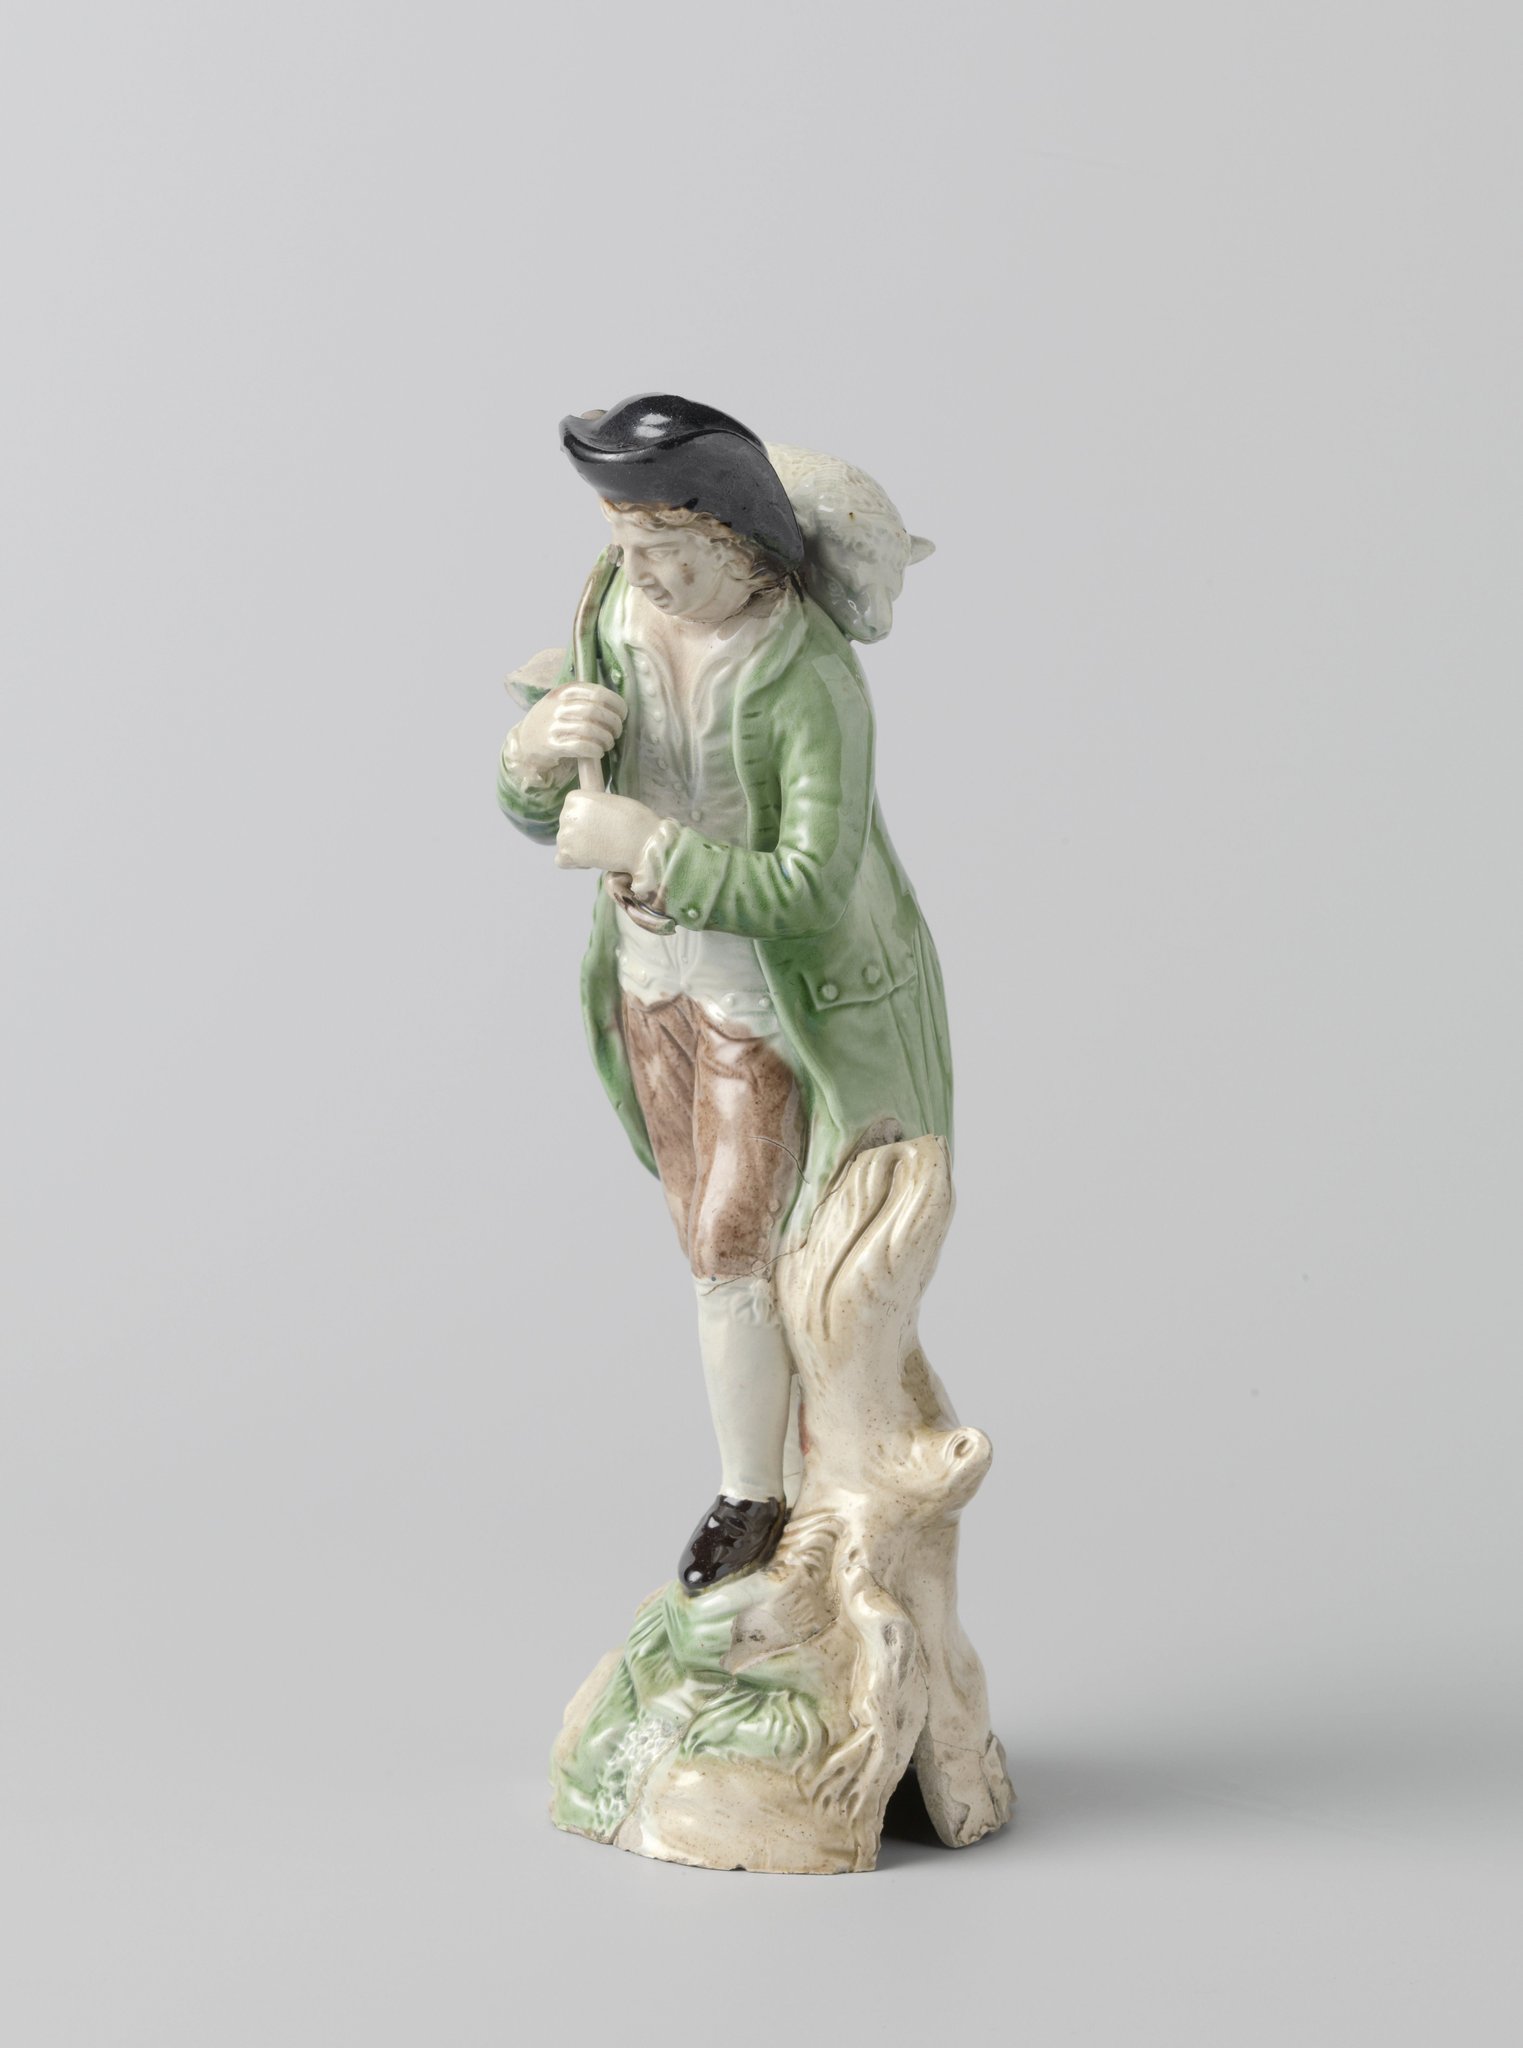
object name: figure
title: Beeld van hardgebakken aardewerk, met veelkleurige decoratie decoratie, Ralph Wood.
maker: ralph wood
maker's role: potter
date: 1775-1790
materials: earthenware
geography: burslem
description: Beeld van hardgebakken aardewerk. Het beeld stelt een man voor met een lam op zijn rug. De man staat op een grond, tegen een boomstronk aan. Het beeld is veelkleurig beschilderd.